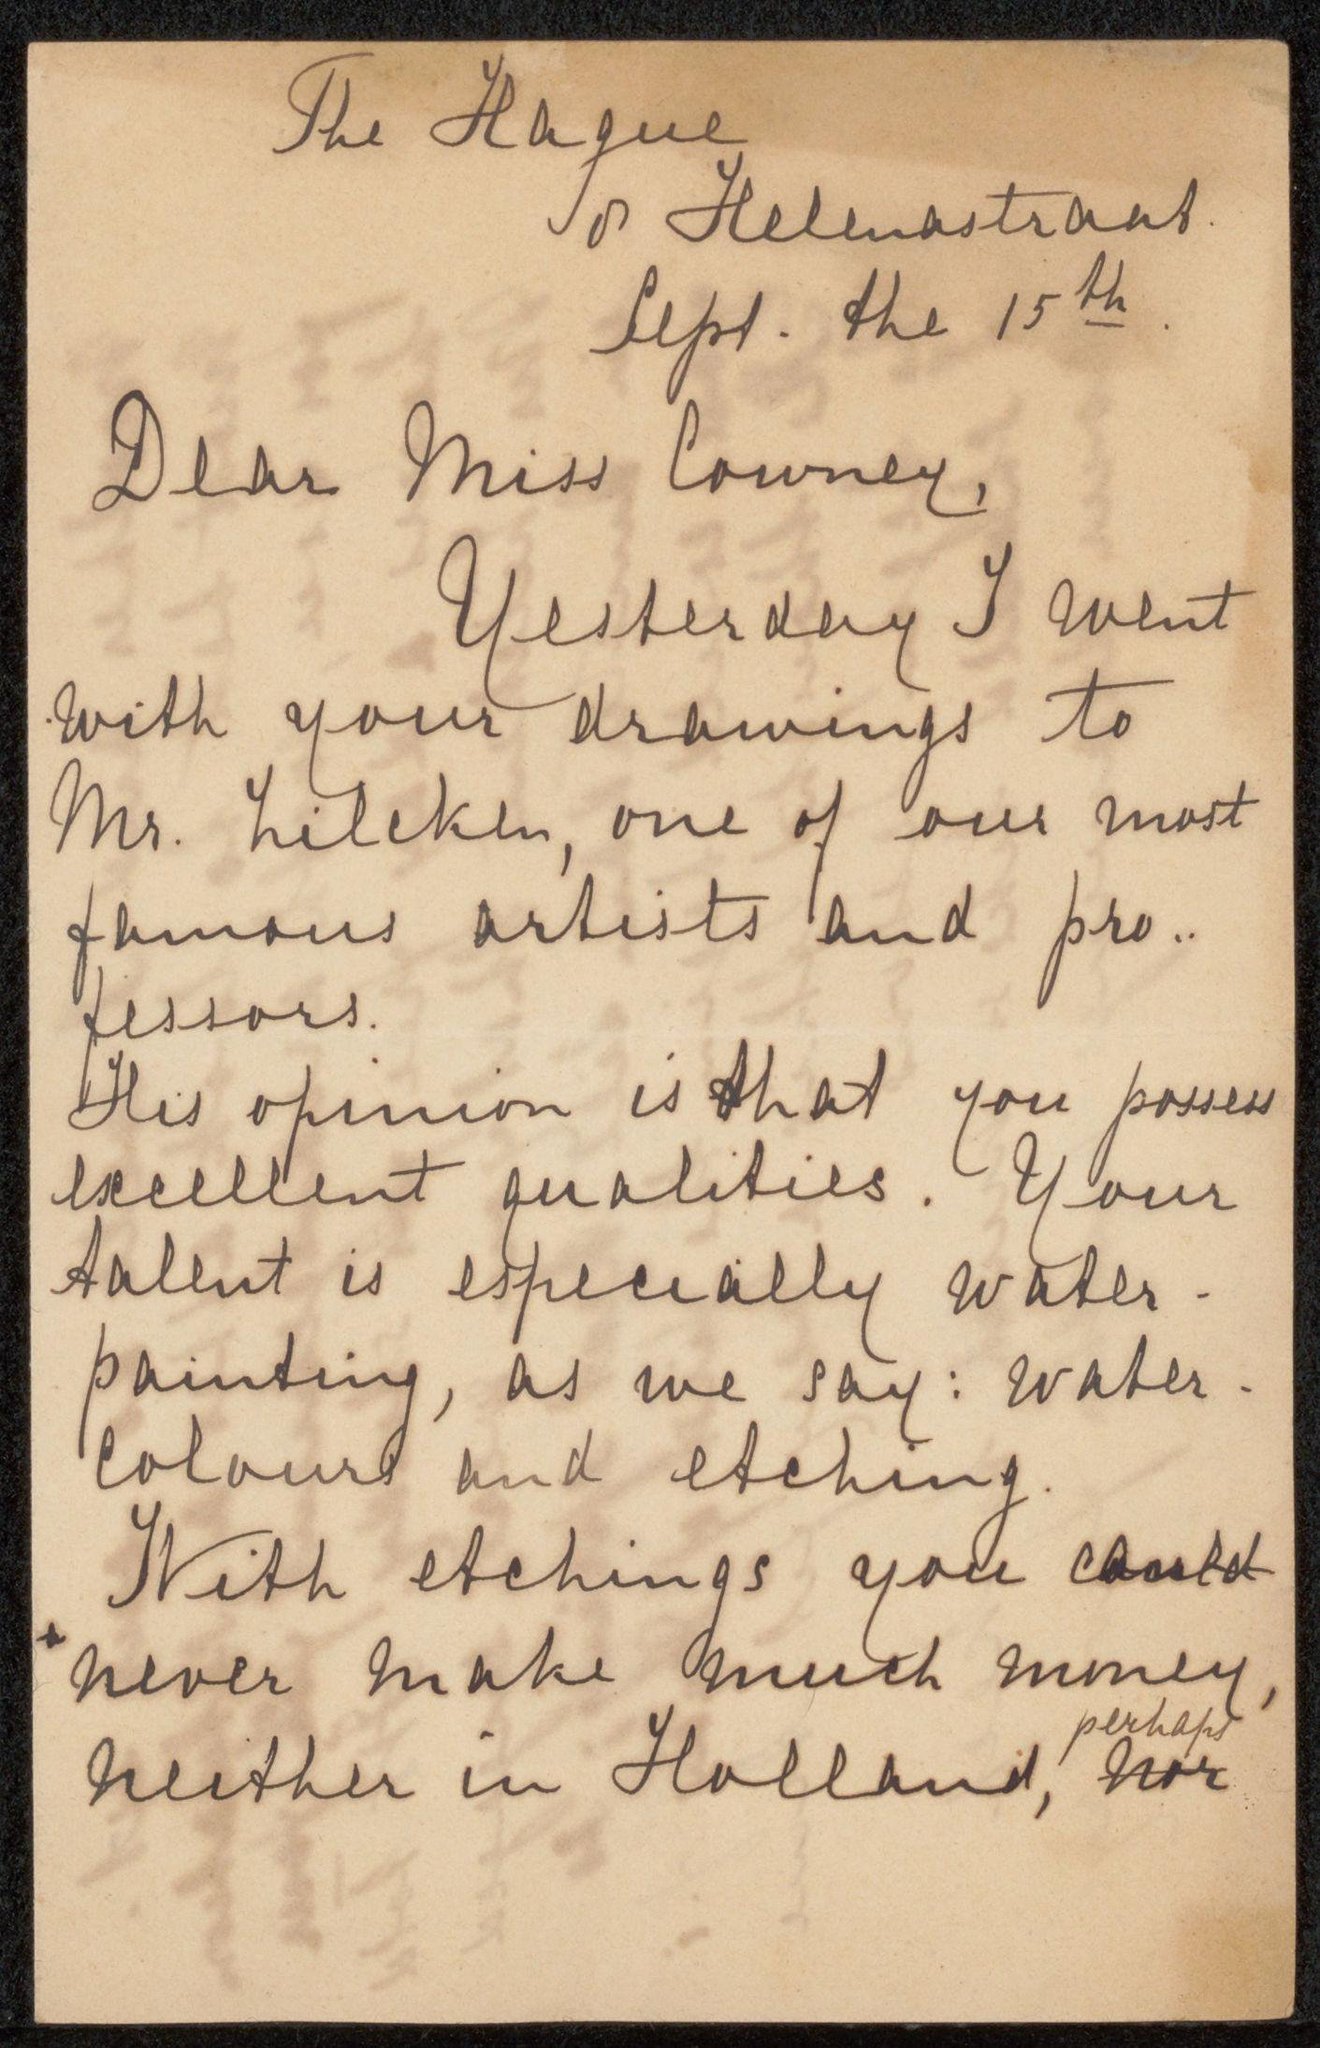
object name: letter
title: Brief aan Elsie Maud Cownie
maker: annie de graaff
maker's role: auteur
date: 1904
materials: ink, paper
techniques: pen, writing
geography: the hague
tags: manchester, the hague, draughtsman, elsie maud cownie, painter, philip zilcken, drawing, the graphic arts, education, tuition of the artist (in general), amsterdam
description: Brief is als bijlage van RP-D-1982-43-269 doorgestuurd aan Philip Zilcken.